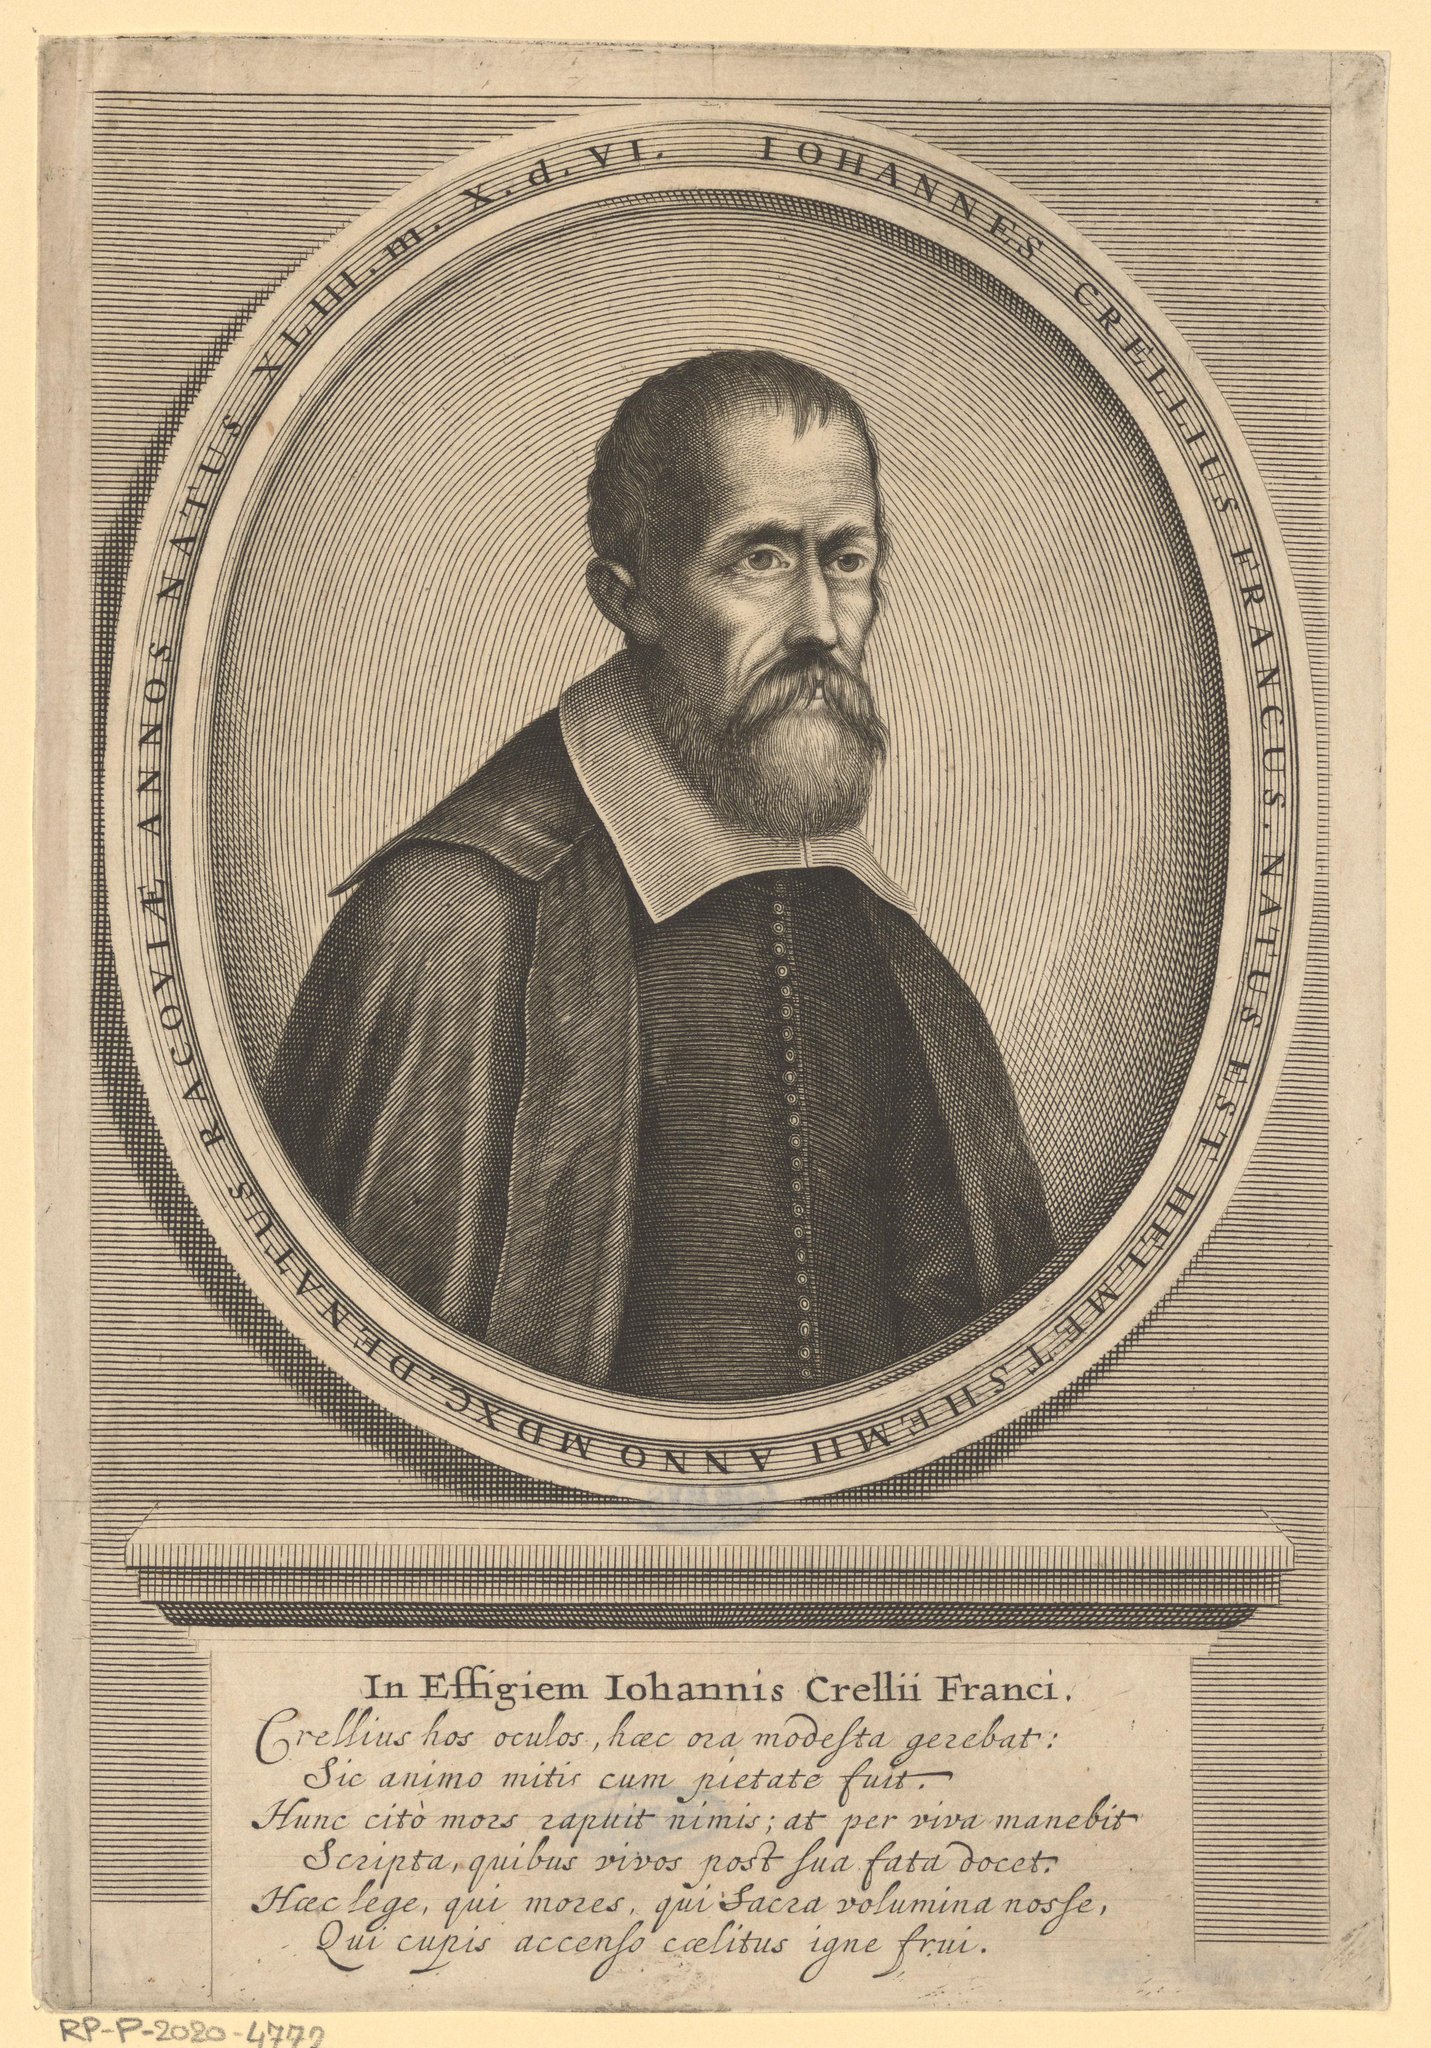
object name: print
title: Portret van Johannes Krellius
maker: lambert visscher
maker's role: draughtsman, print maker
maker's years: 1640-1679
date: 1643-1690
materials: paper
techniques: engraving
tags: publisher, johannes krellius, historical persons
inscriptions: watermark: ‘AM’, collector's mark: Lugt 2228